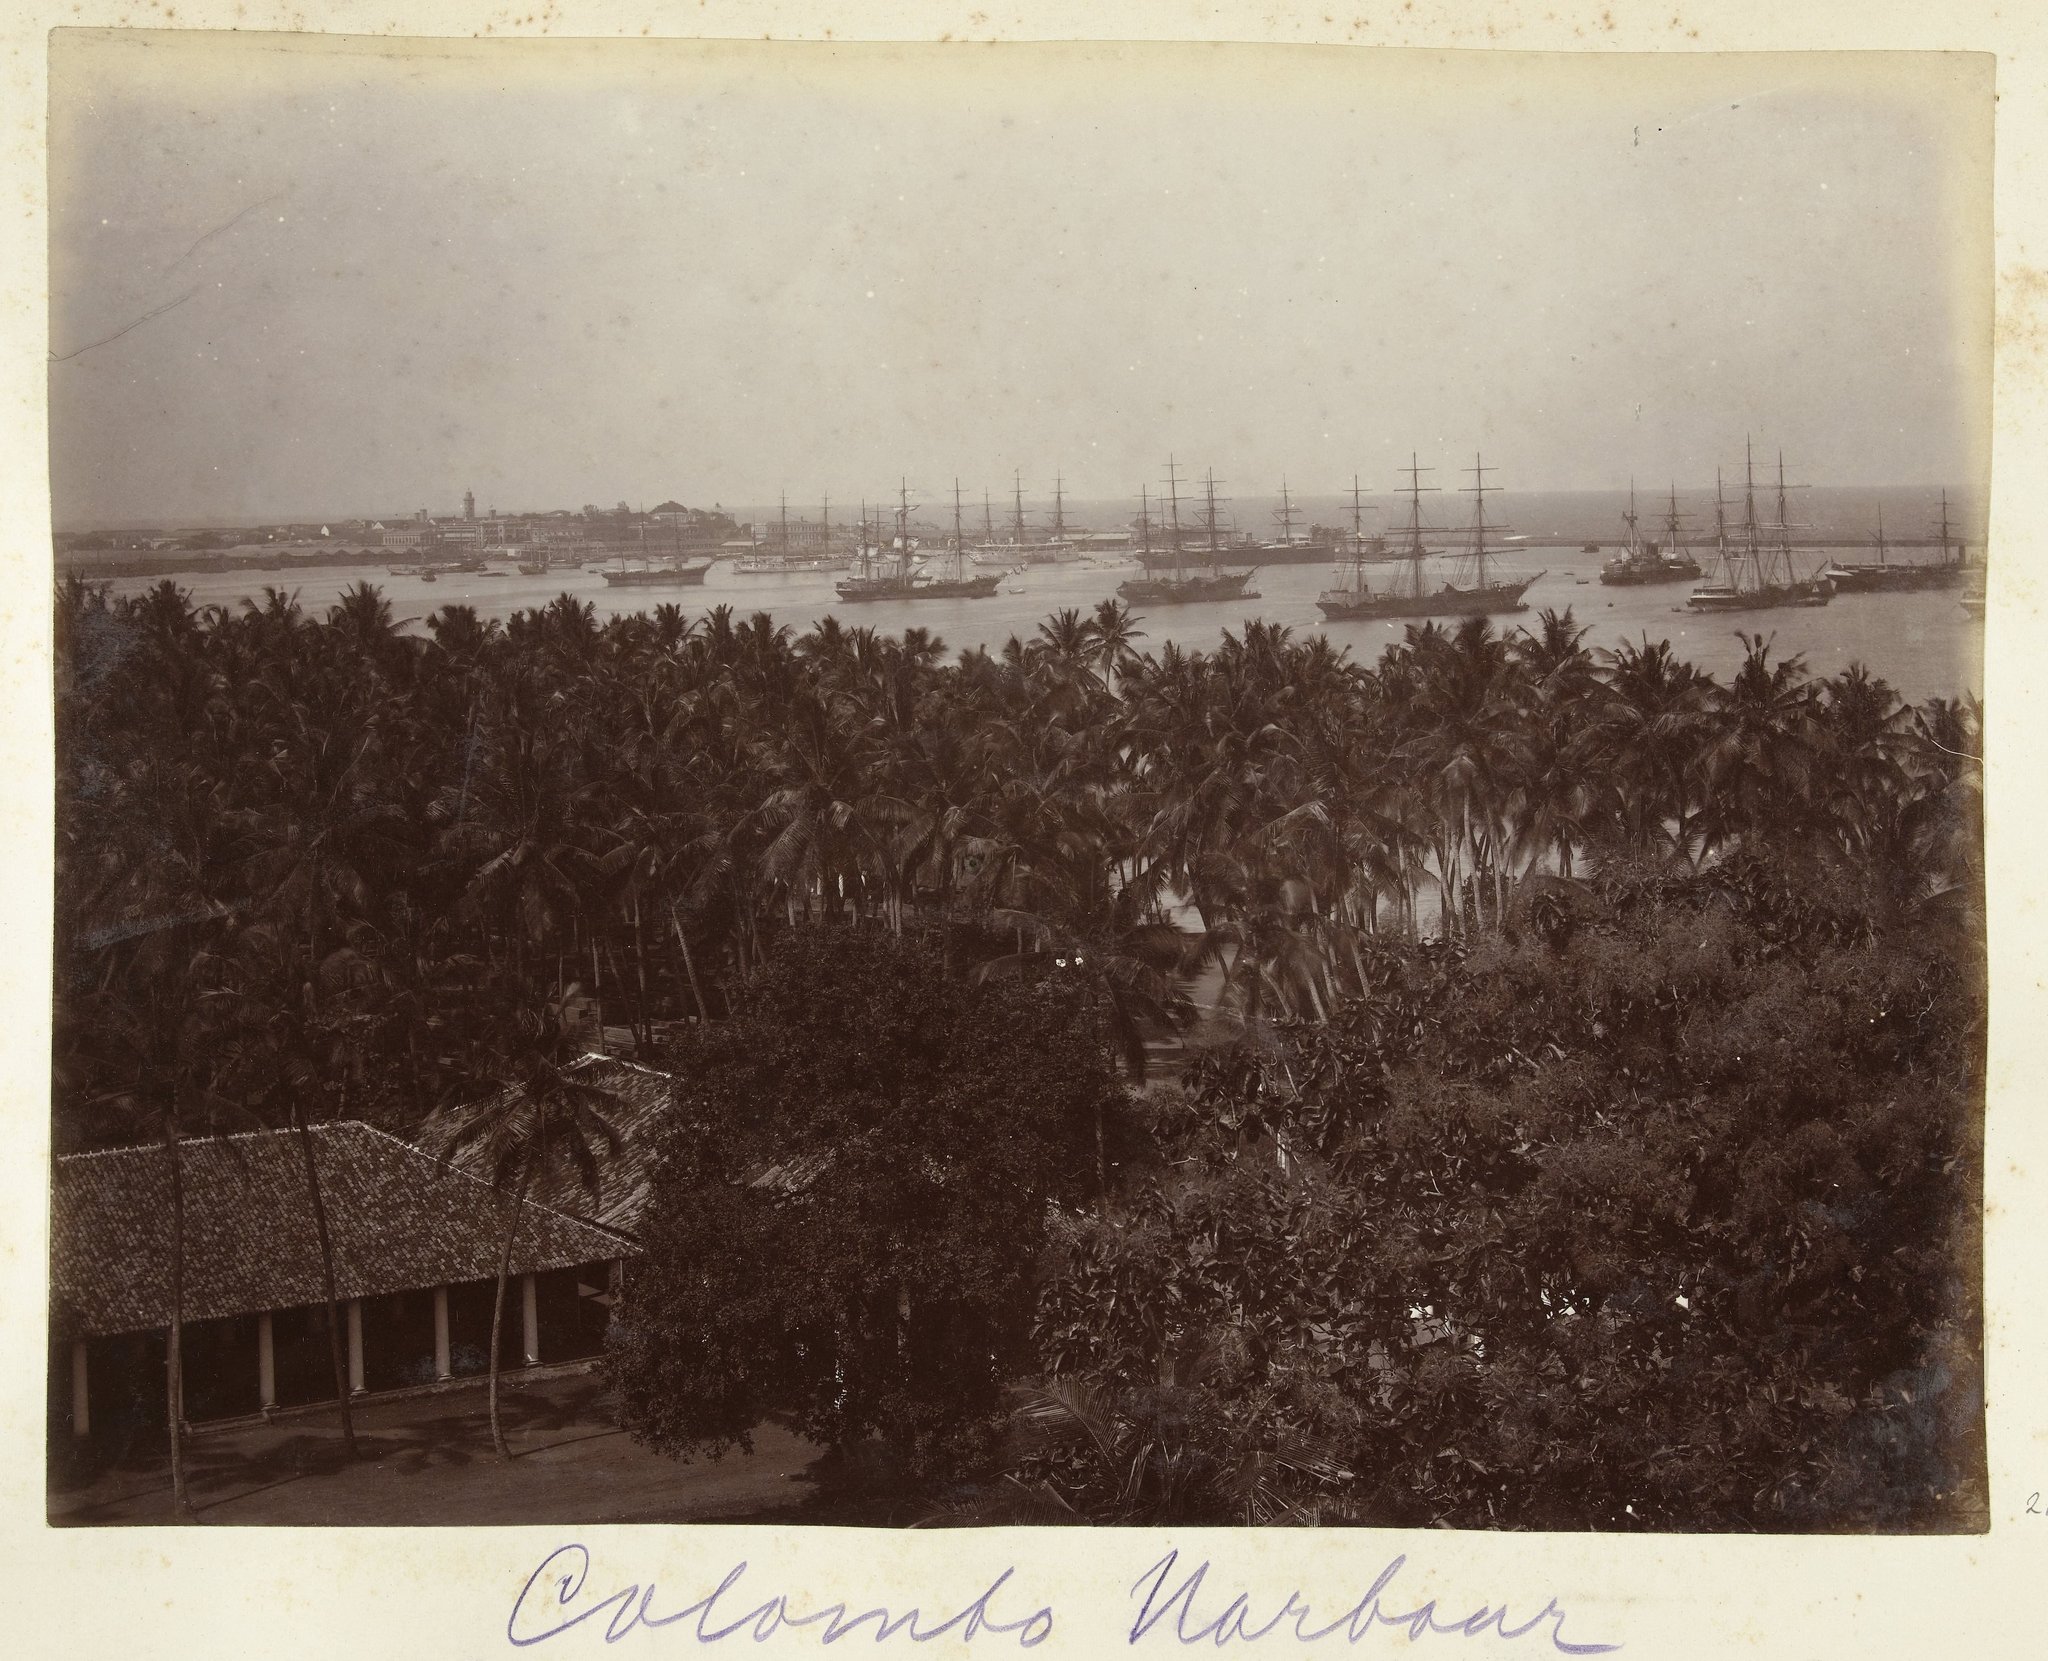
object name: photograph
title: Schepen voor anker in de haven van Colombo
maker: Anonymous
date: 1890-1910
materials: cardboard, paper, photographic support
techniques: gelatin silver print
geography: netherlands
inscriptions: caption: ‘Colombo Harbour’